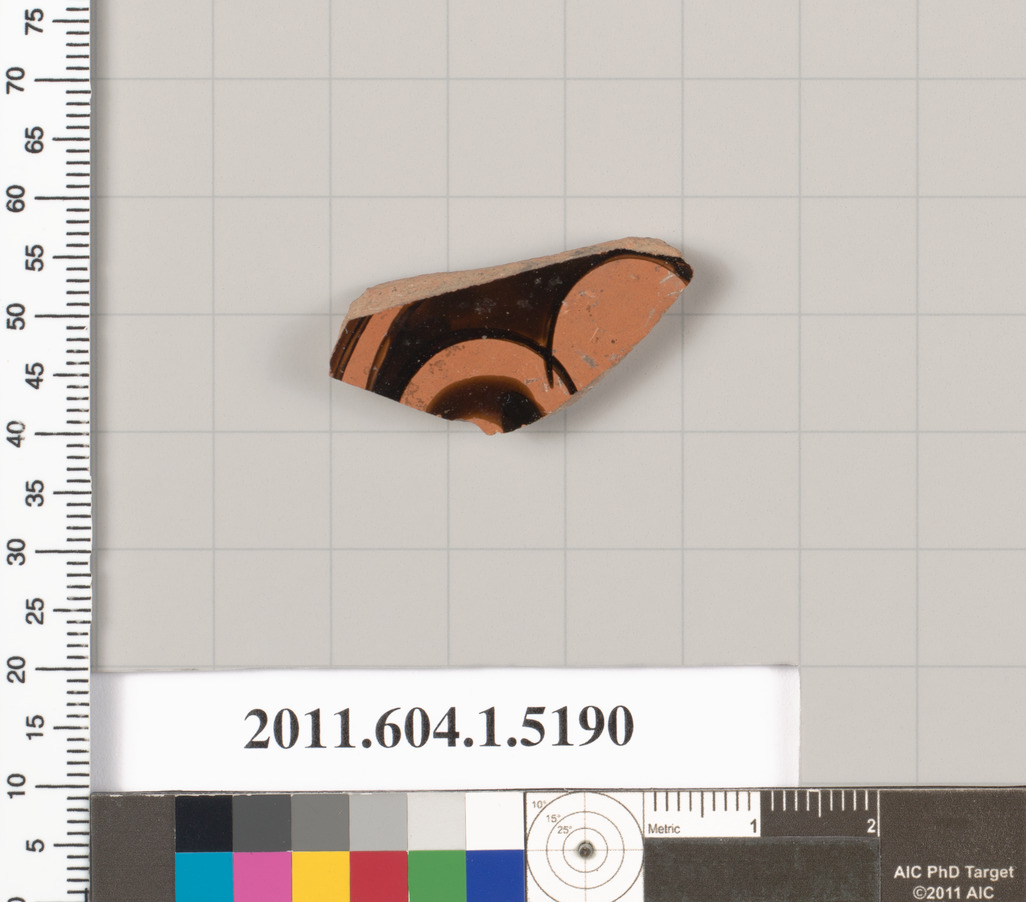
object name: kylix fragment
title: Terracotta fragment of a kylix (drinking cup)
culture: greek, attic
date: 475-451 BCE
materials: terracotta